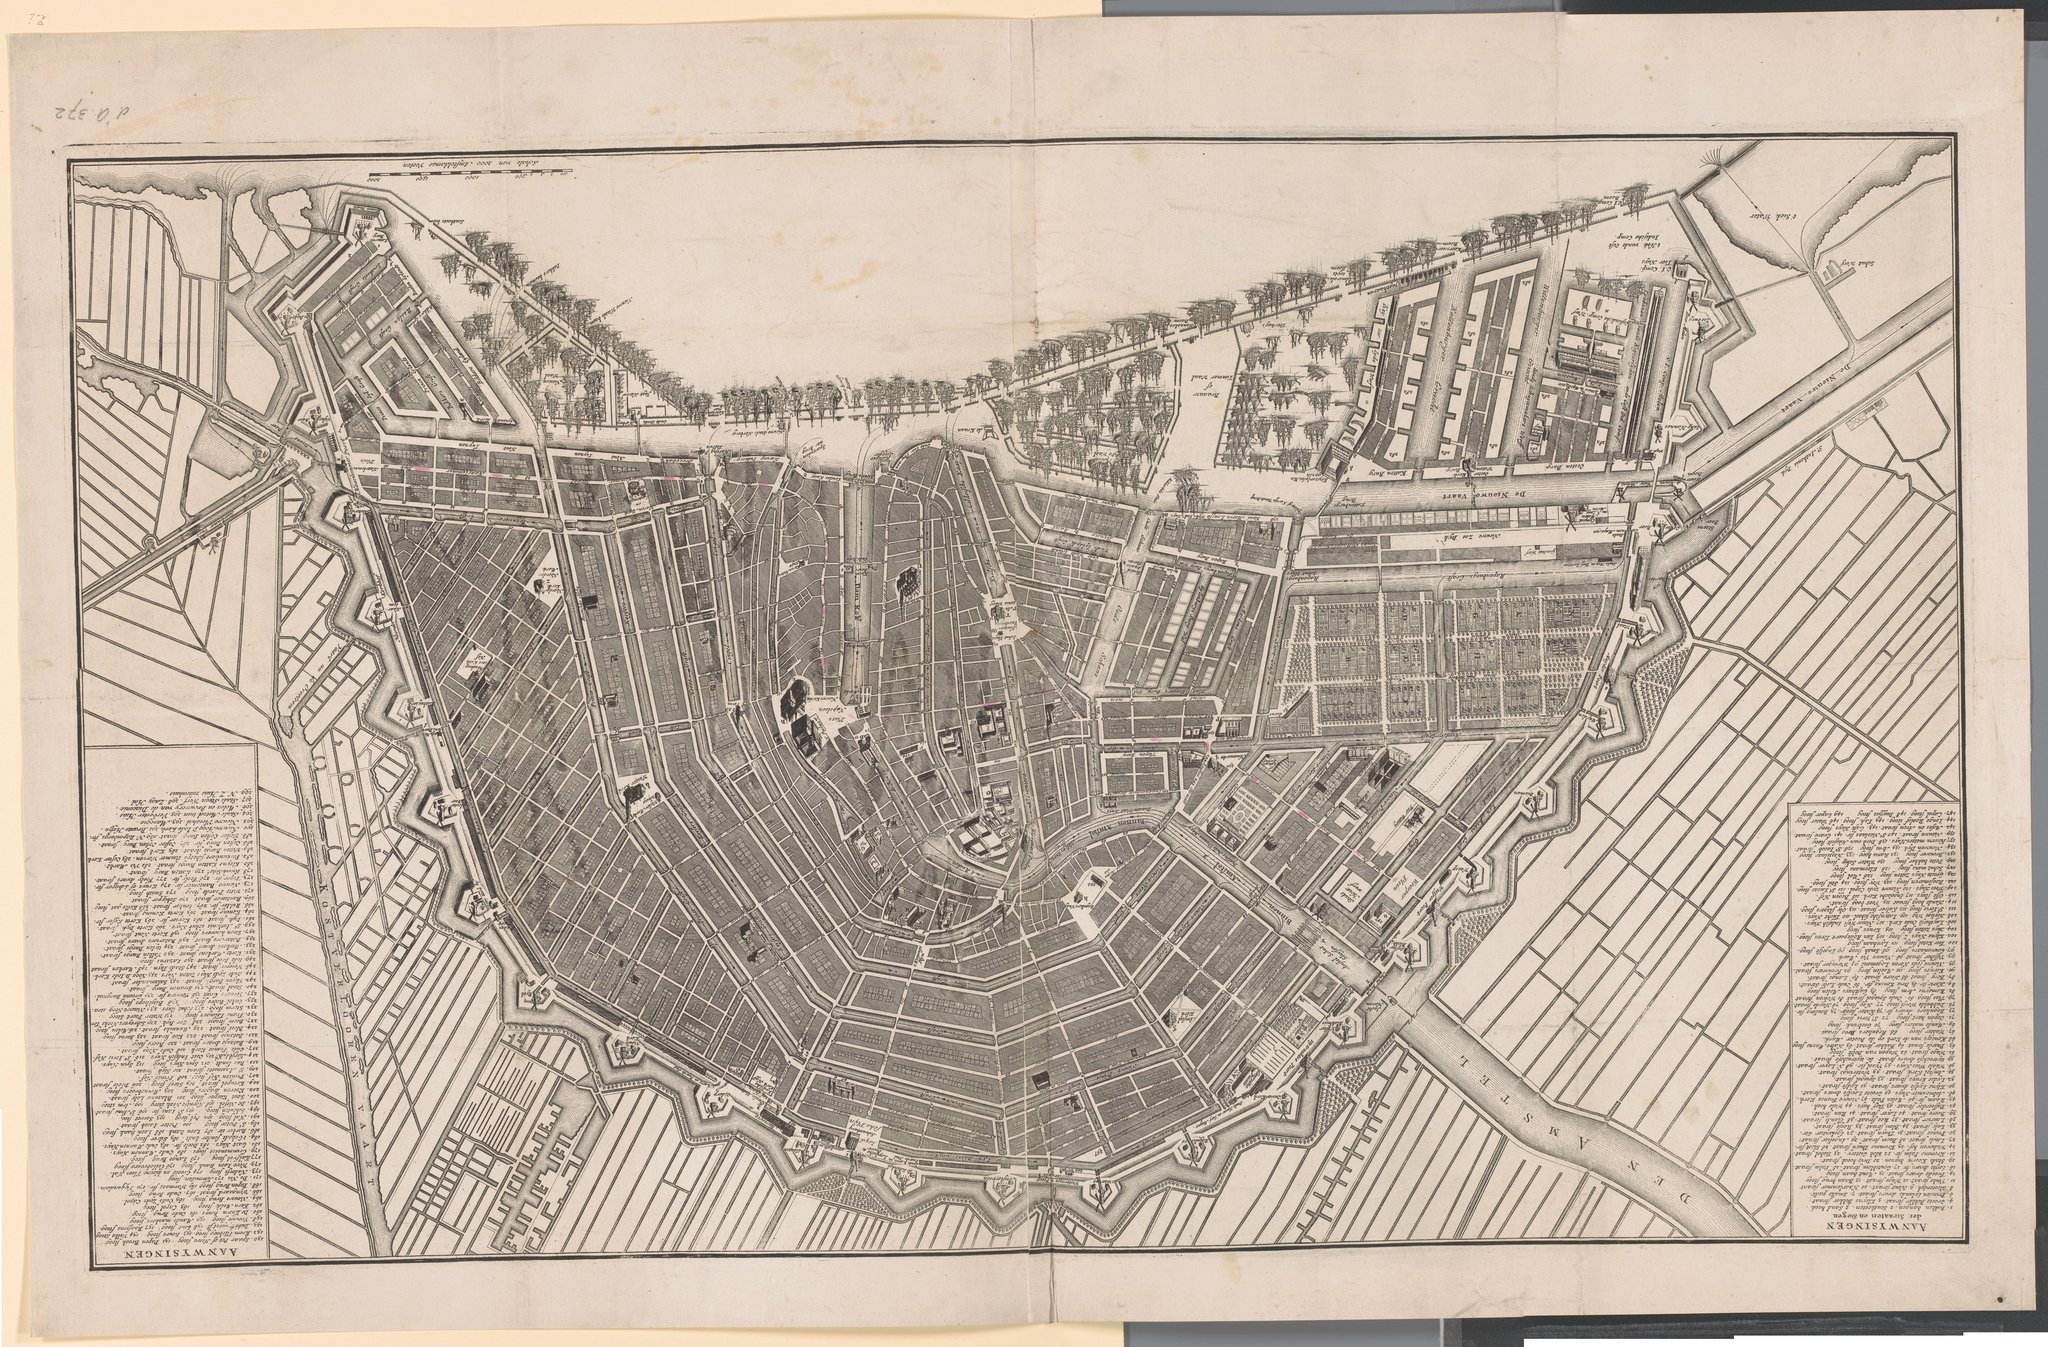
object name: area plan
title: Plattegrond van Amsterdam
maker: Anonymous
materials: paper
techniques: engraving, etching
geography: amsterdam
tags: maps of cities, amsterdam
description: In de vijfde staat werd de titelcartouche met de titel 'Plan de la Grande & Fameuse Ville Marchande d'Amsterdam' uit de plaat geklopt. De eerste staat van de prent werd rond 1715 uitgegeven door de weduwe van Nicolaes Visscher.